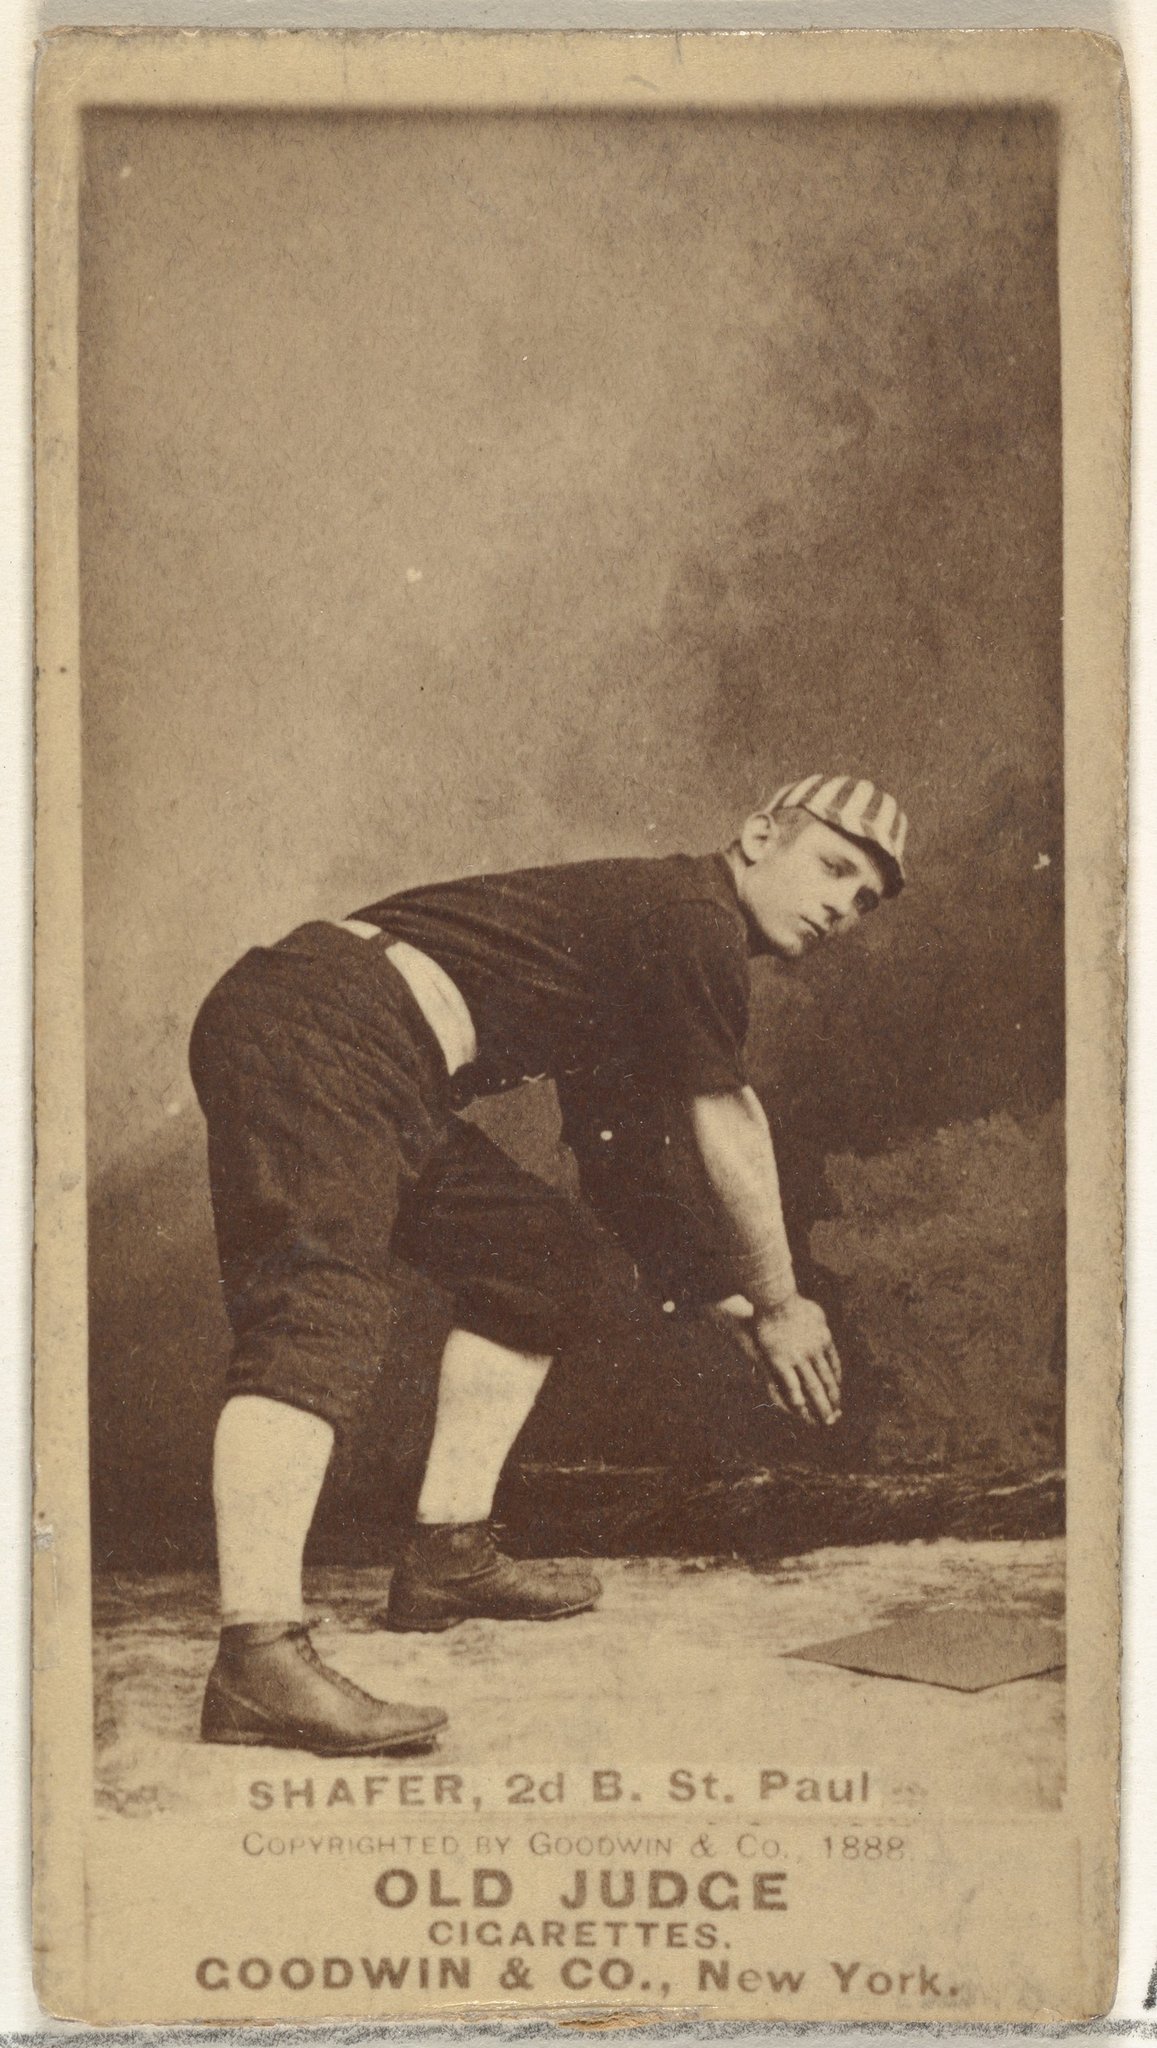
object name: baseball card, photograph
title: Zachary Taylor Shafer, 2nd Base, St. Paul Apostles, from the Old Judge series (N172) for Old Judge Cigarettes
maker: goodwin & company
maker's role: publisher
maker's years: 1850-1950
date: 1888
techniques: albumen silver print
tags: men,portraits,baseball,athletes